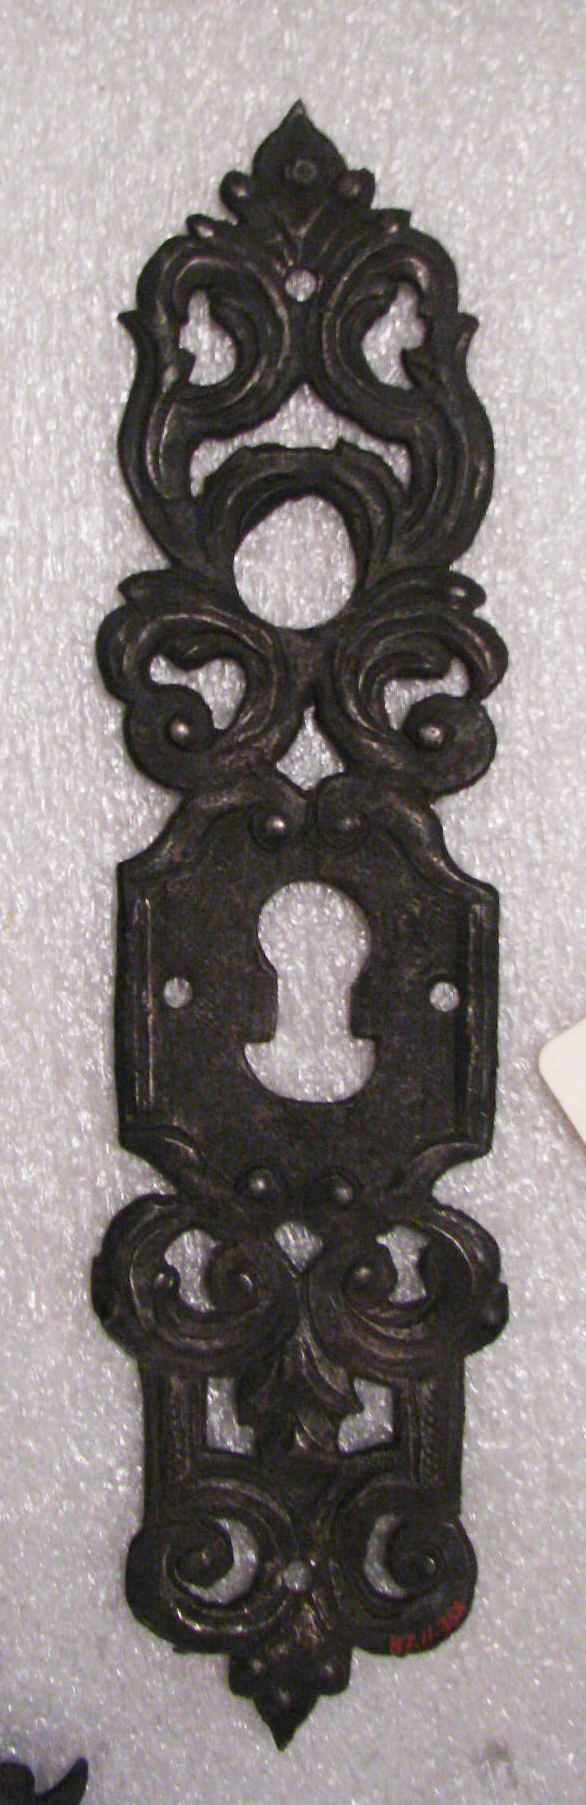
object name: escutcheon with lock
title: Escutcheon of lock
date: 1701-1800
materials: iron